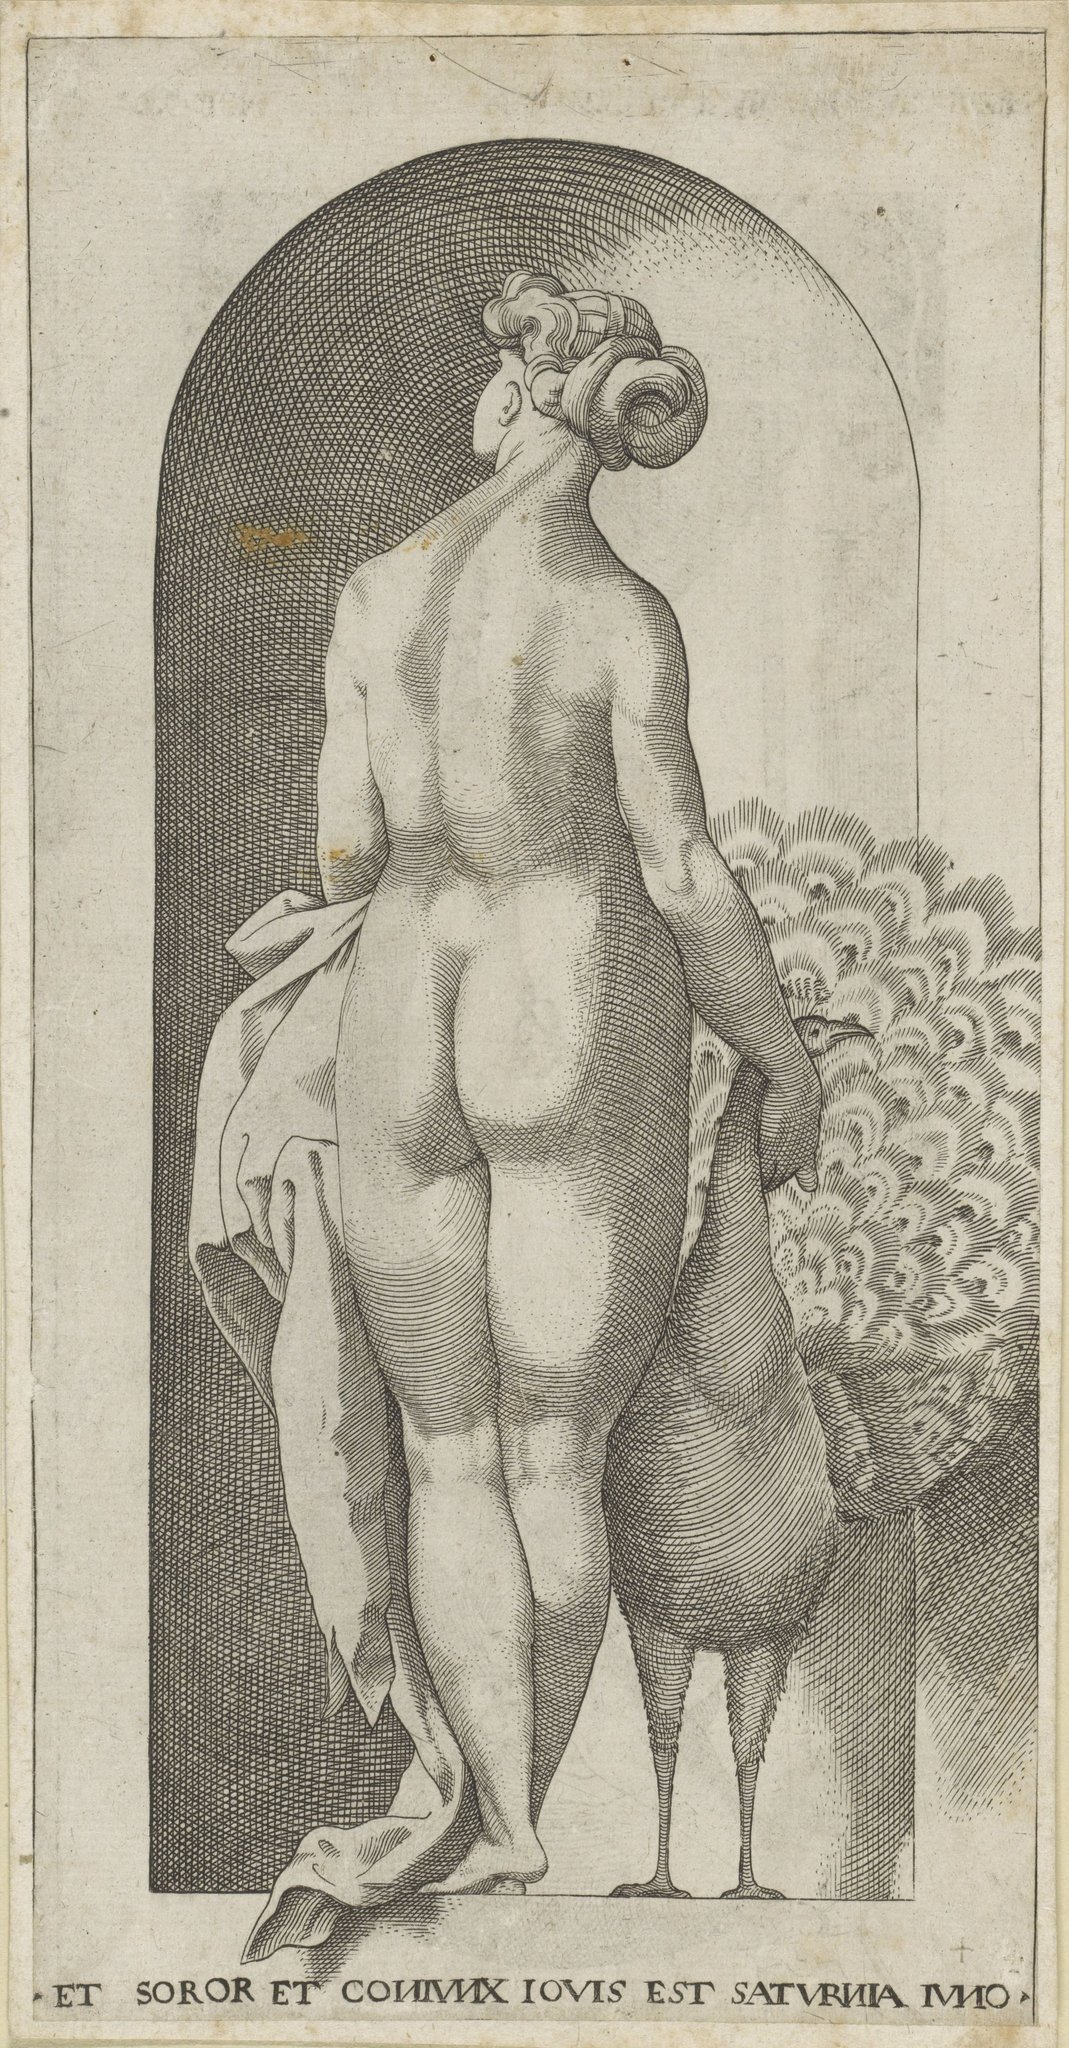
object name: print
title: Goden in nissen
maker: jacob binck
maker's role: painter, print maker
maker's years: 1494-1569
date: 1510-1569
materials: paper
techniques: engraving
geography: italy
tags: attributes of juno, (story of) juno (hera)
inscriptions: collector's mark: Lugt 11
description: De godin Juno, van achteren gezien, staat met een pauw in een nis.